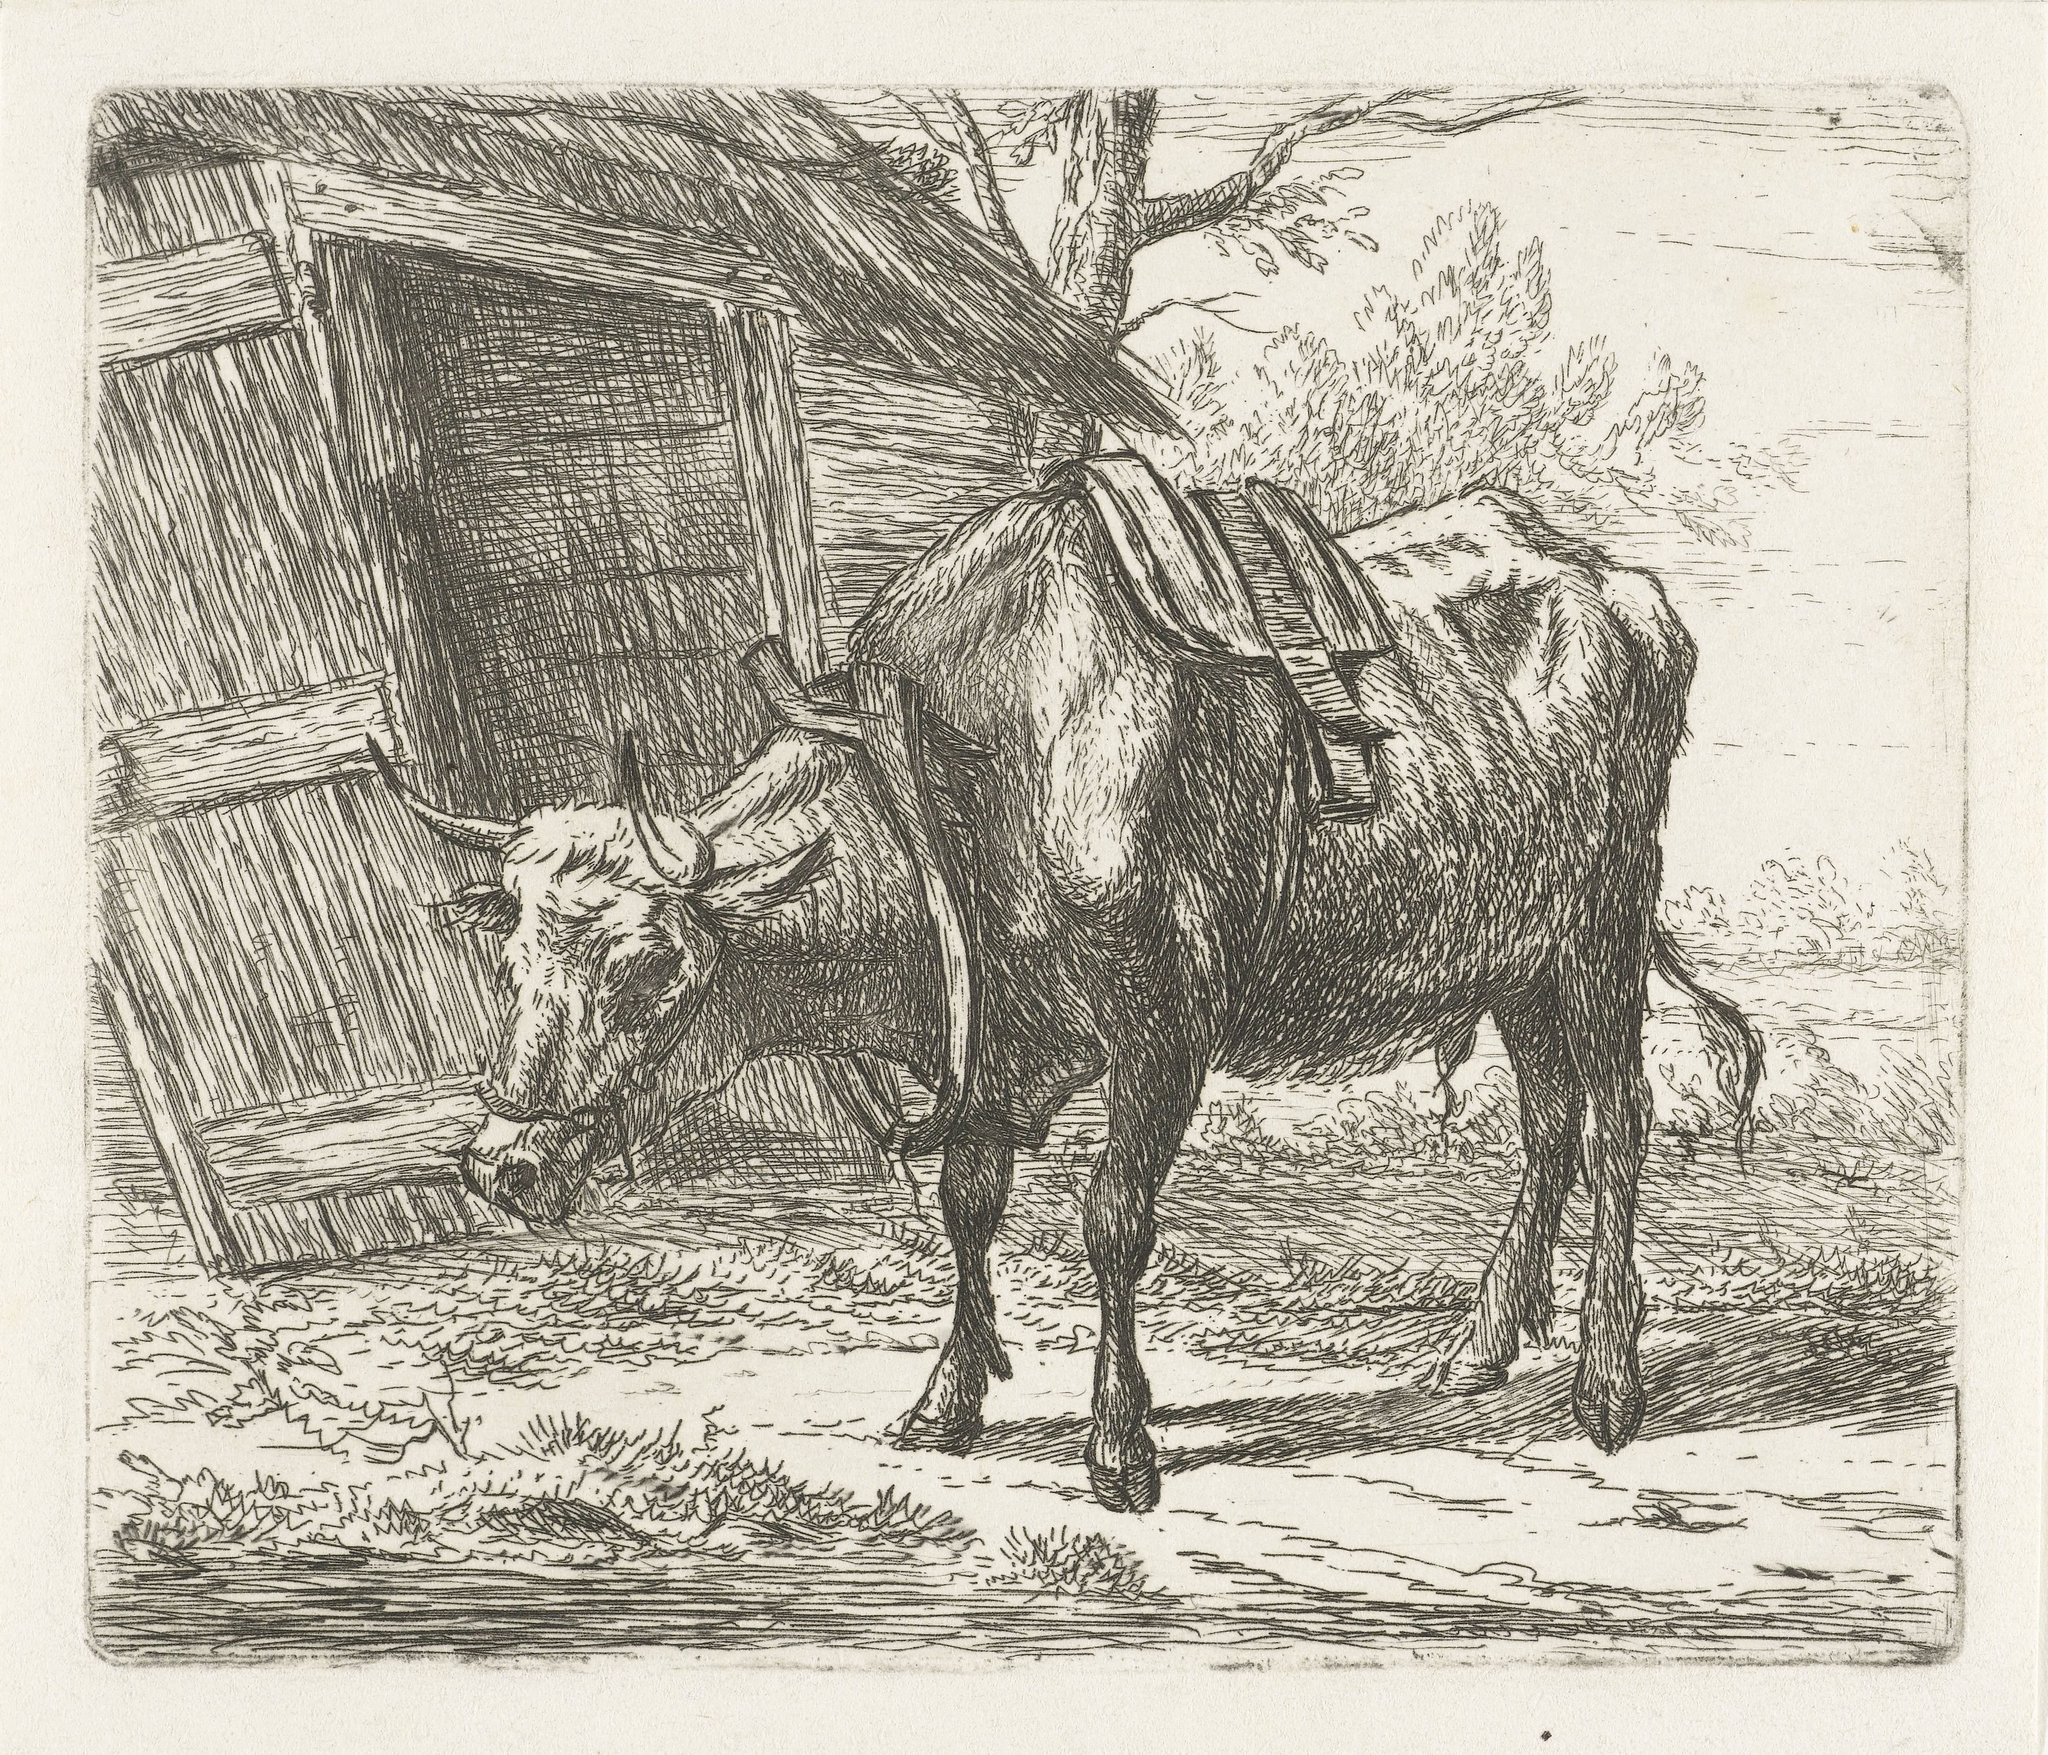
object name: print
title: Trekos met juk voor de stal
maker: jacobus cornelis gaal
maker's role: print maker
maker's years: 1796-1866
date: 1851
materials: paper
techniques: etching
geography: netherlands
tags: barn, ox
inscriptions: collector's mark: Lugt 2228